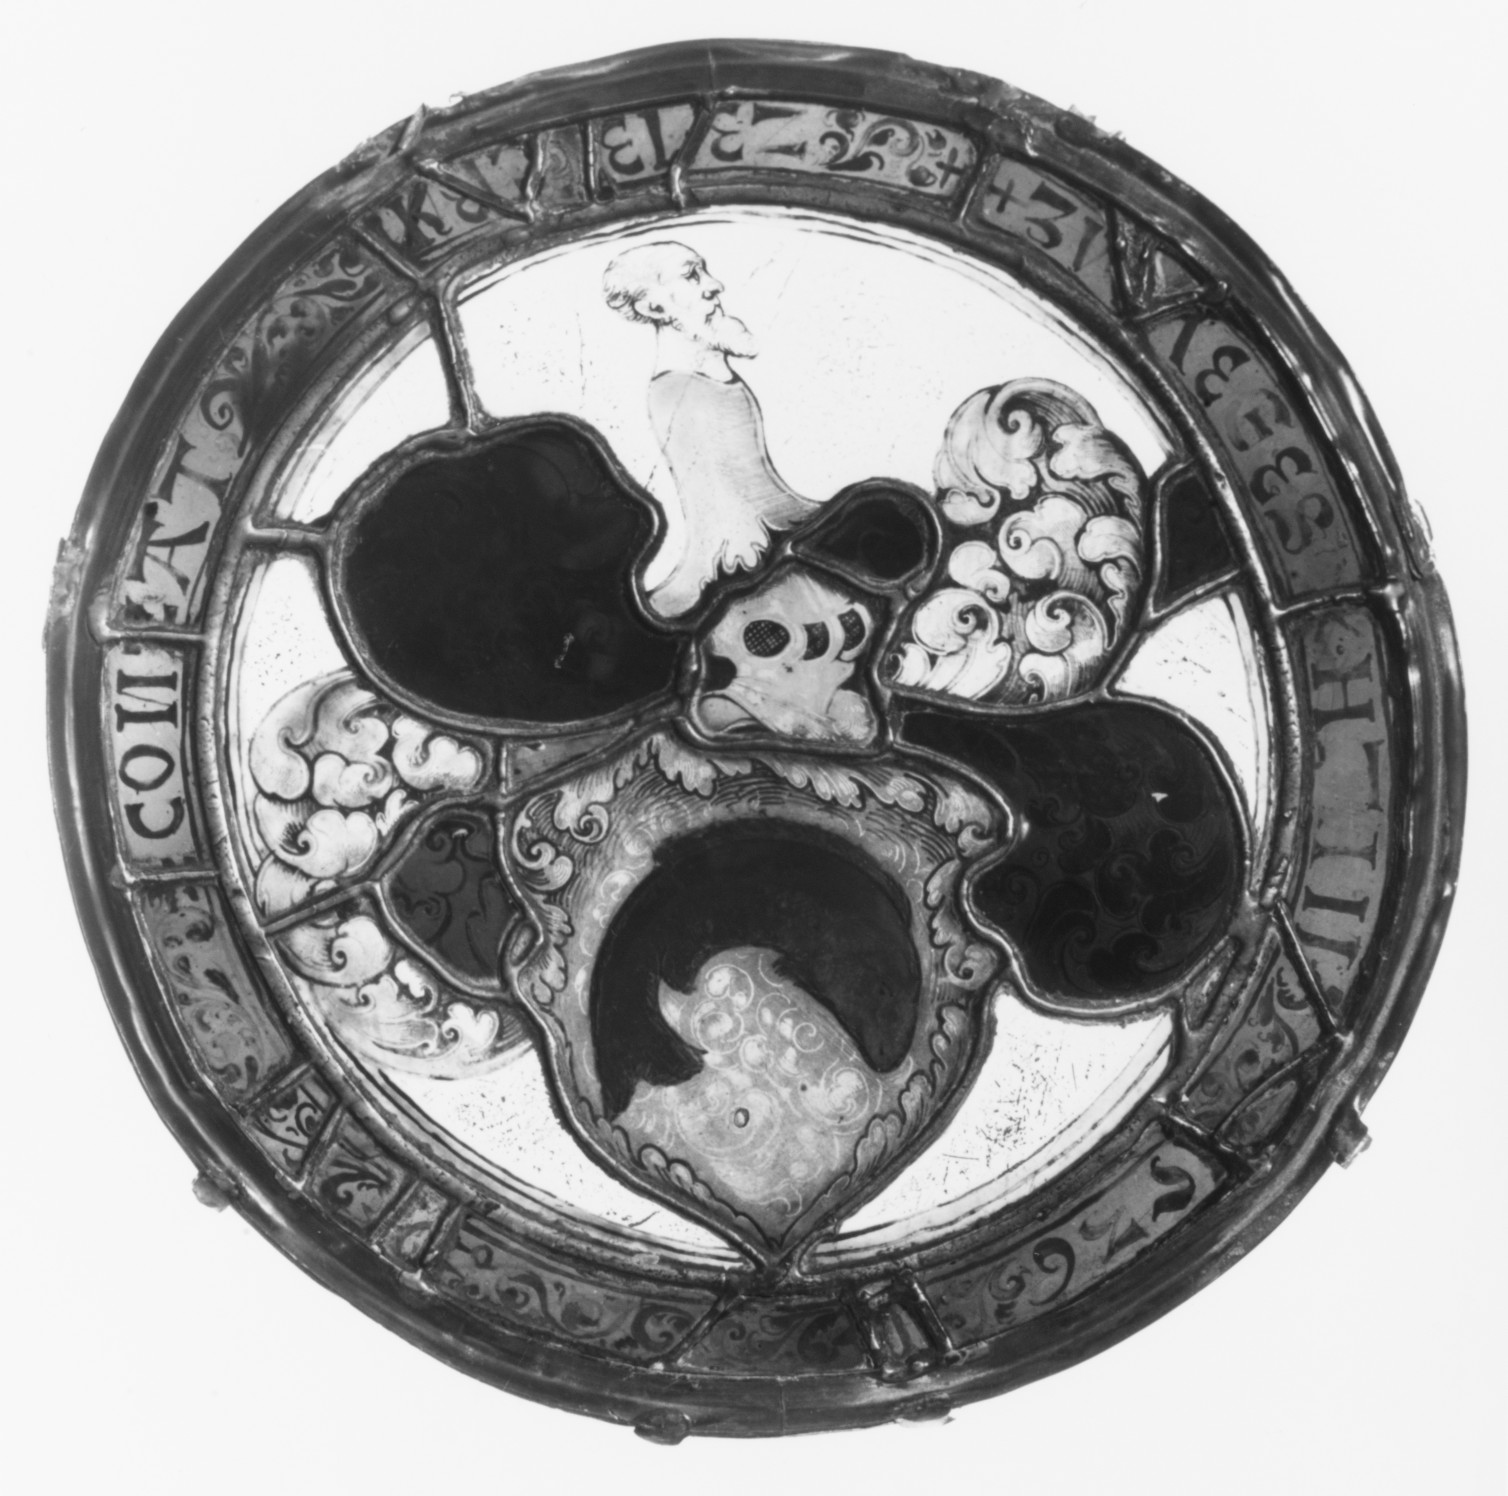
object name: roundel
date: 1536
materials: glass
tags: men